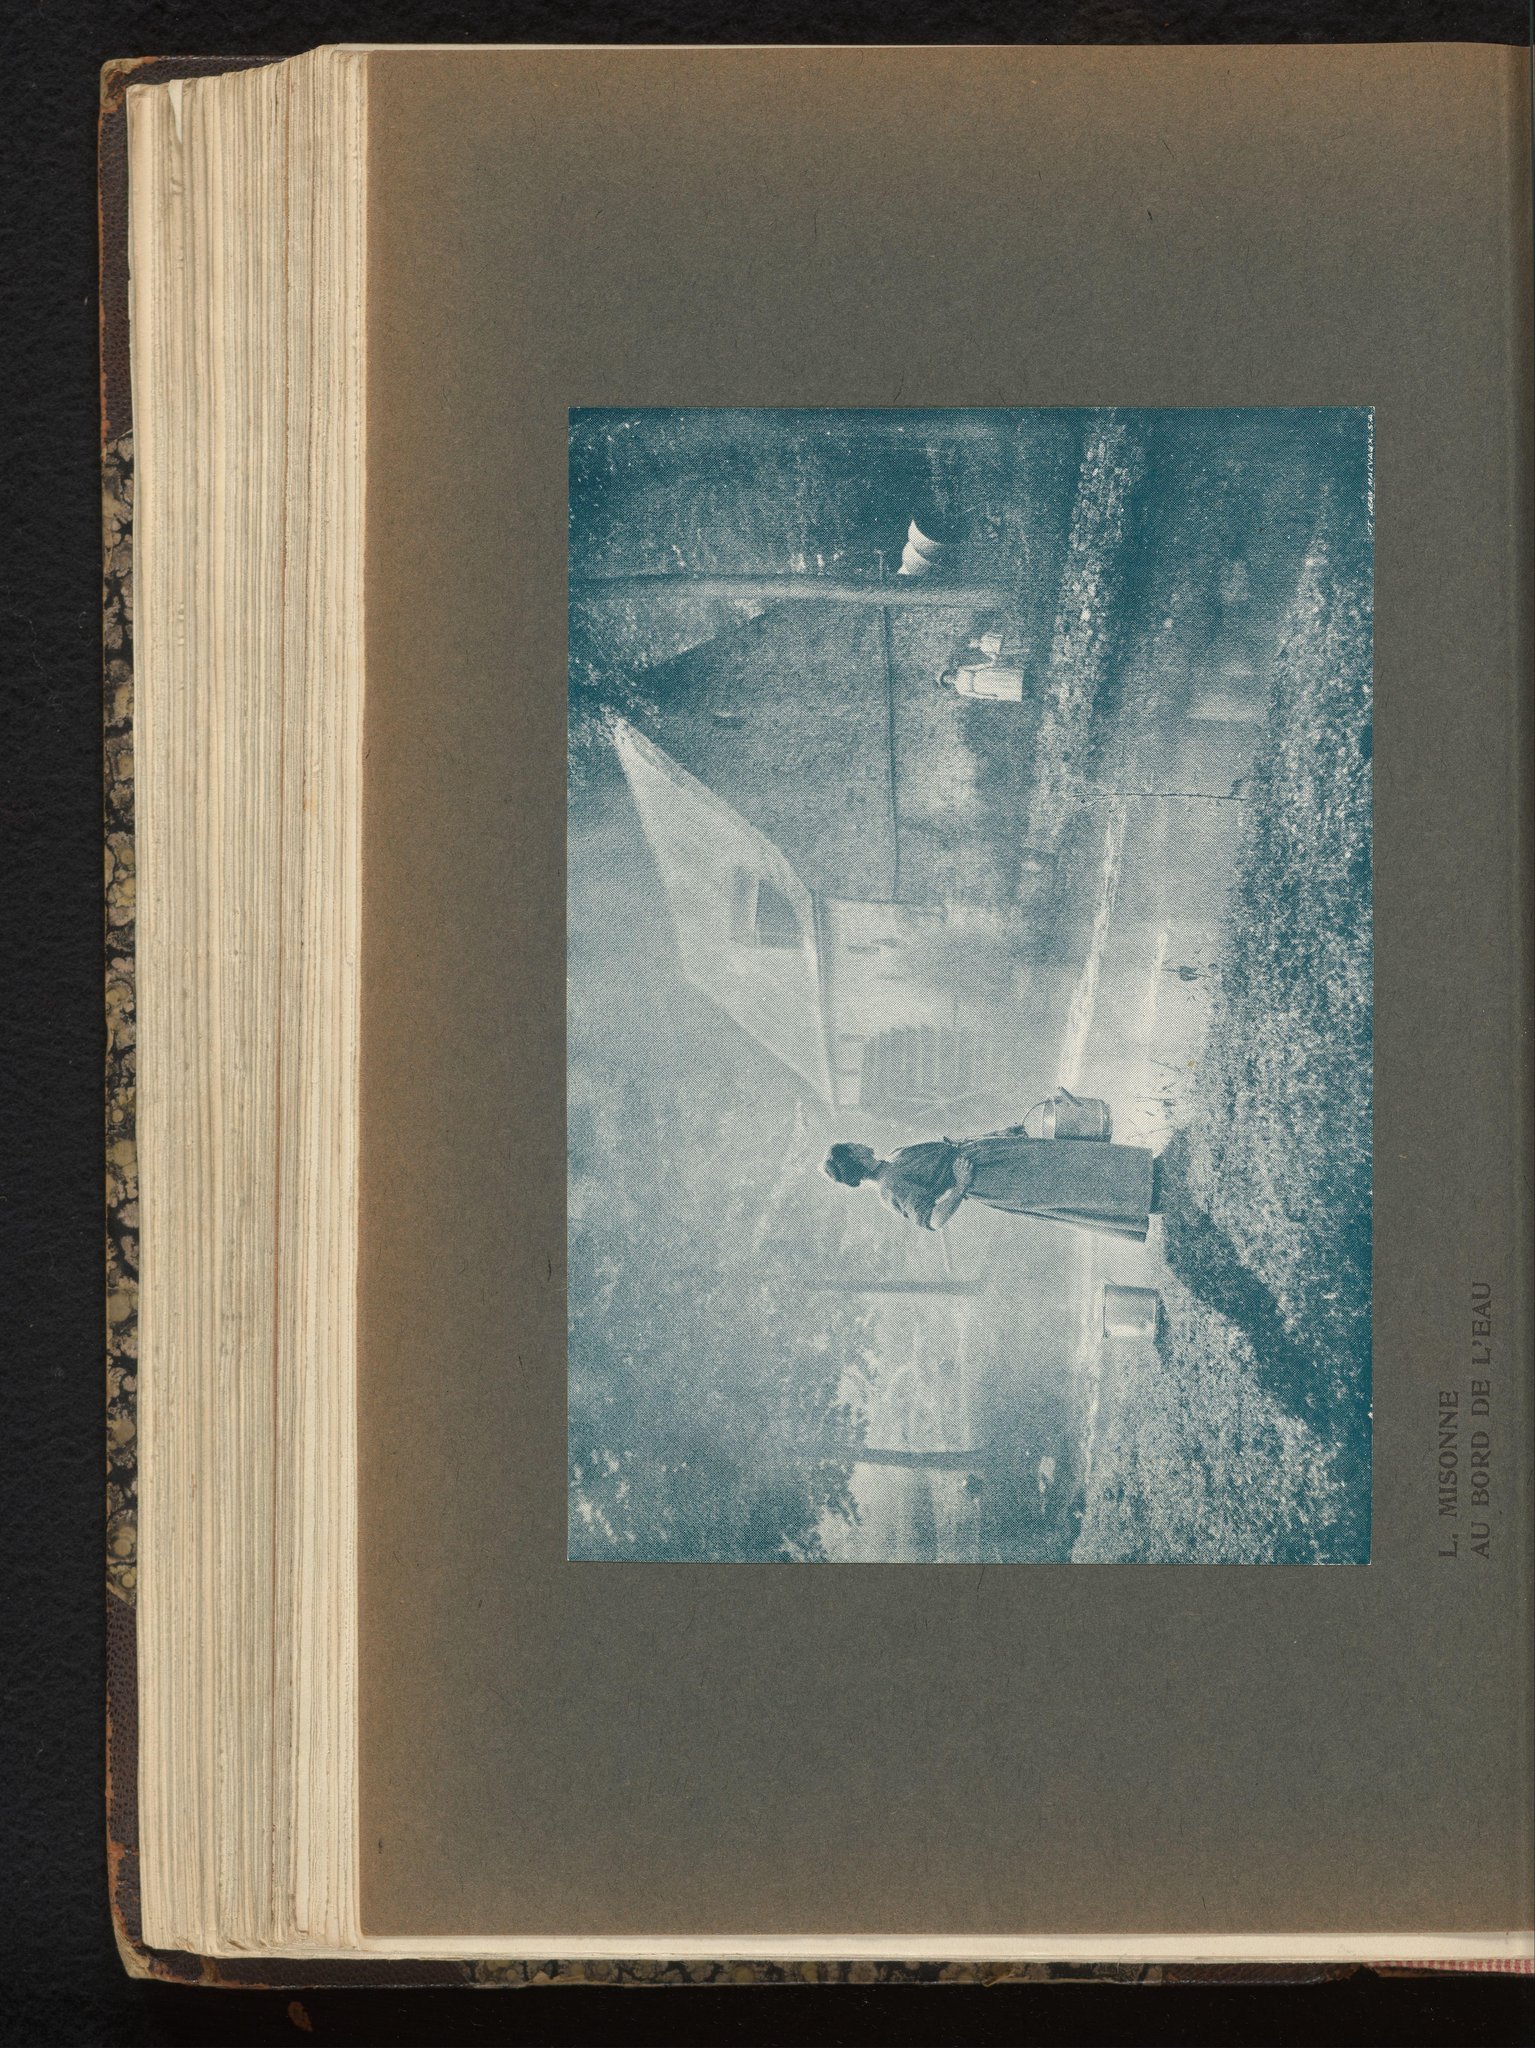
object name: photomechanical print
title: Twee onbekende vrouwen bij een watermolen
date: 1897-1902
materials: paper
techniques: autotype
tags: adult woman, watermill